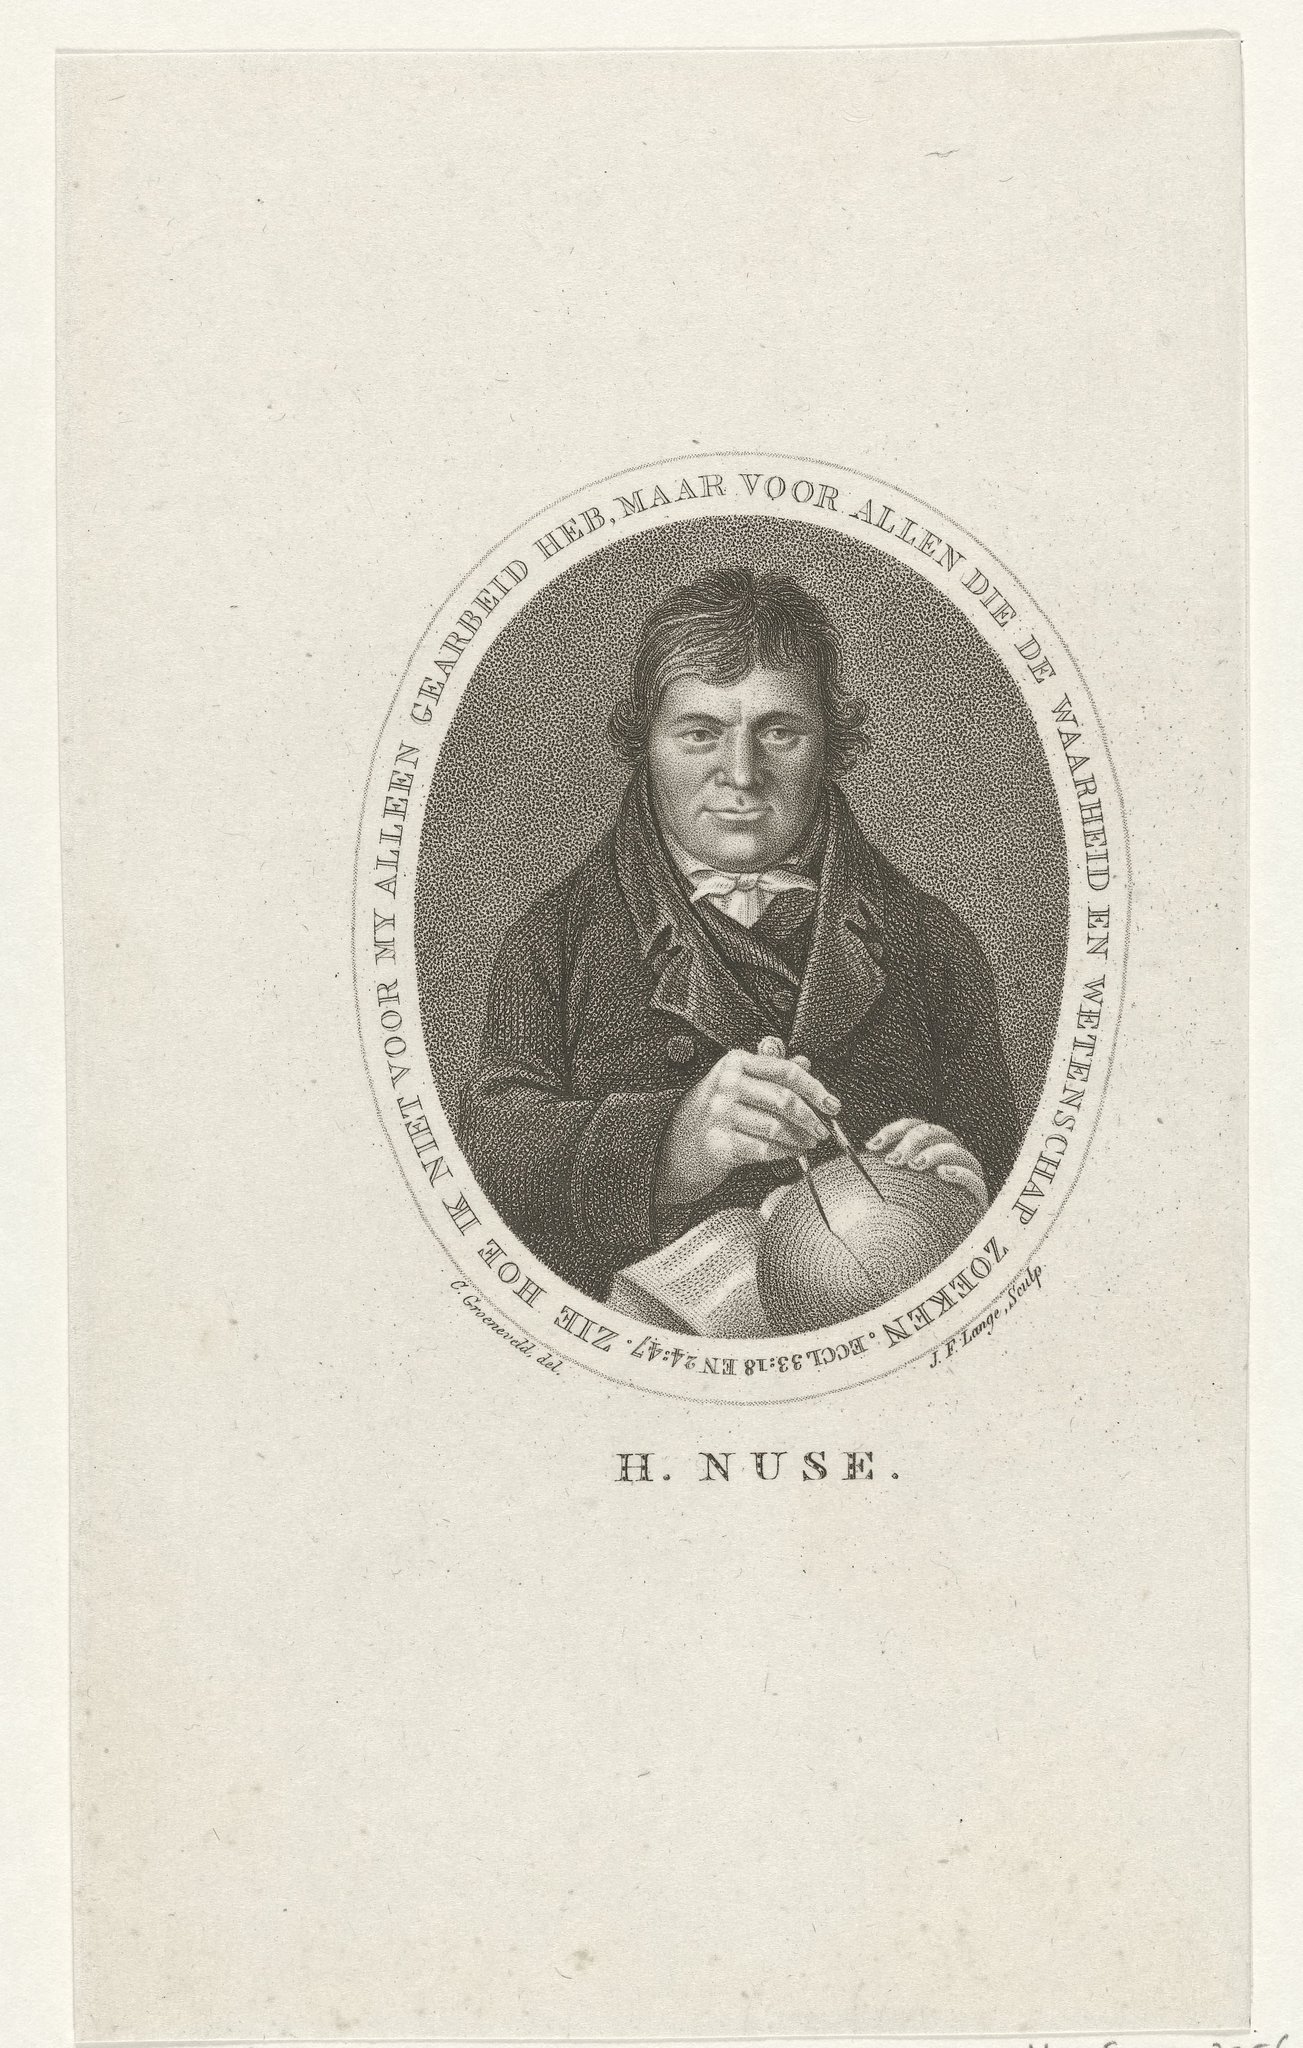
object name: print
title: Portret van H. Nuse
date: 1785-1828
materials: paper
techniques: engraving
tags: h. nuse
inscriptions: collector's mark: Lugt 2228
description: Portret in ovaal van H. Nuse, mystiek schrijver te Rotterdam, blootshoofds. Rond het portret staat een randschrift in het Nederlands.